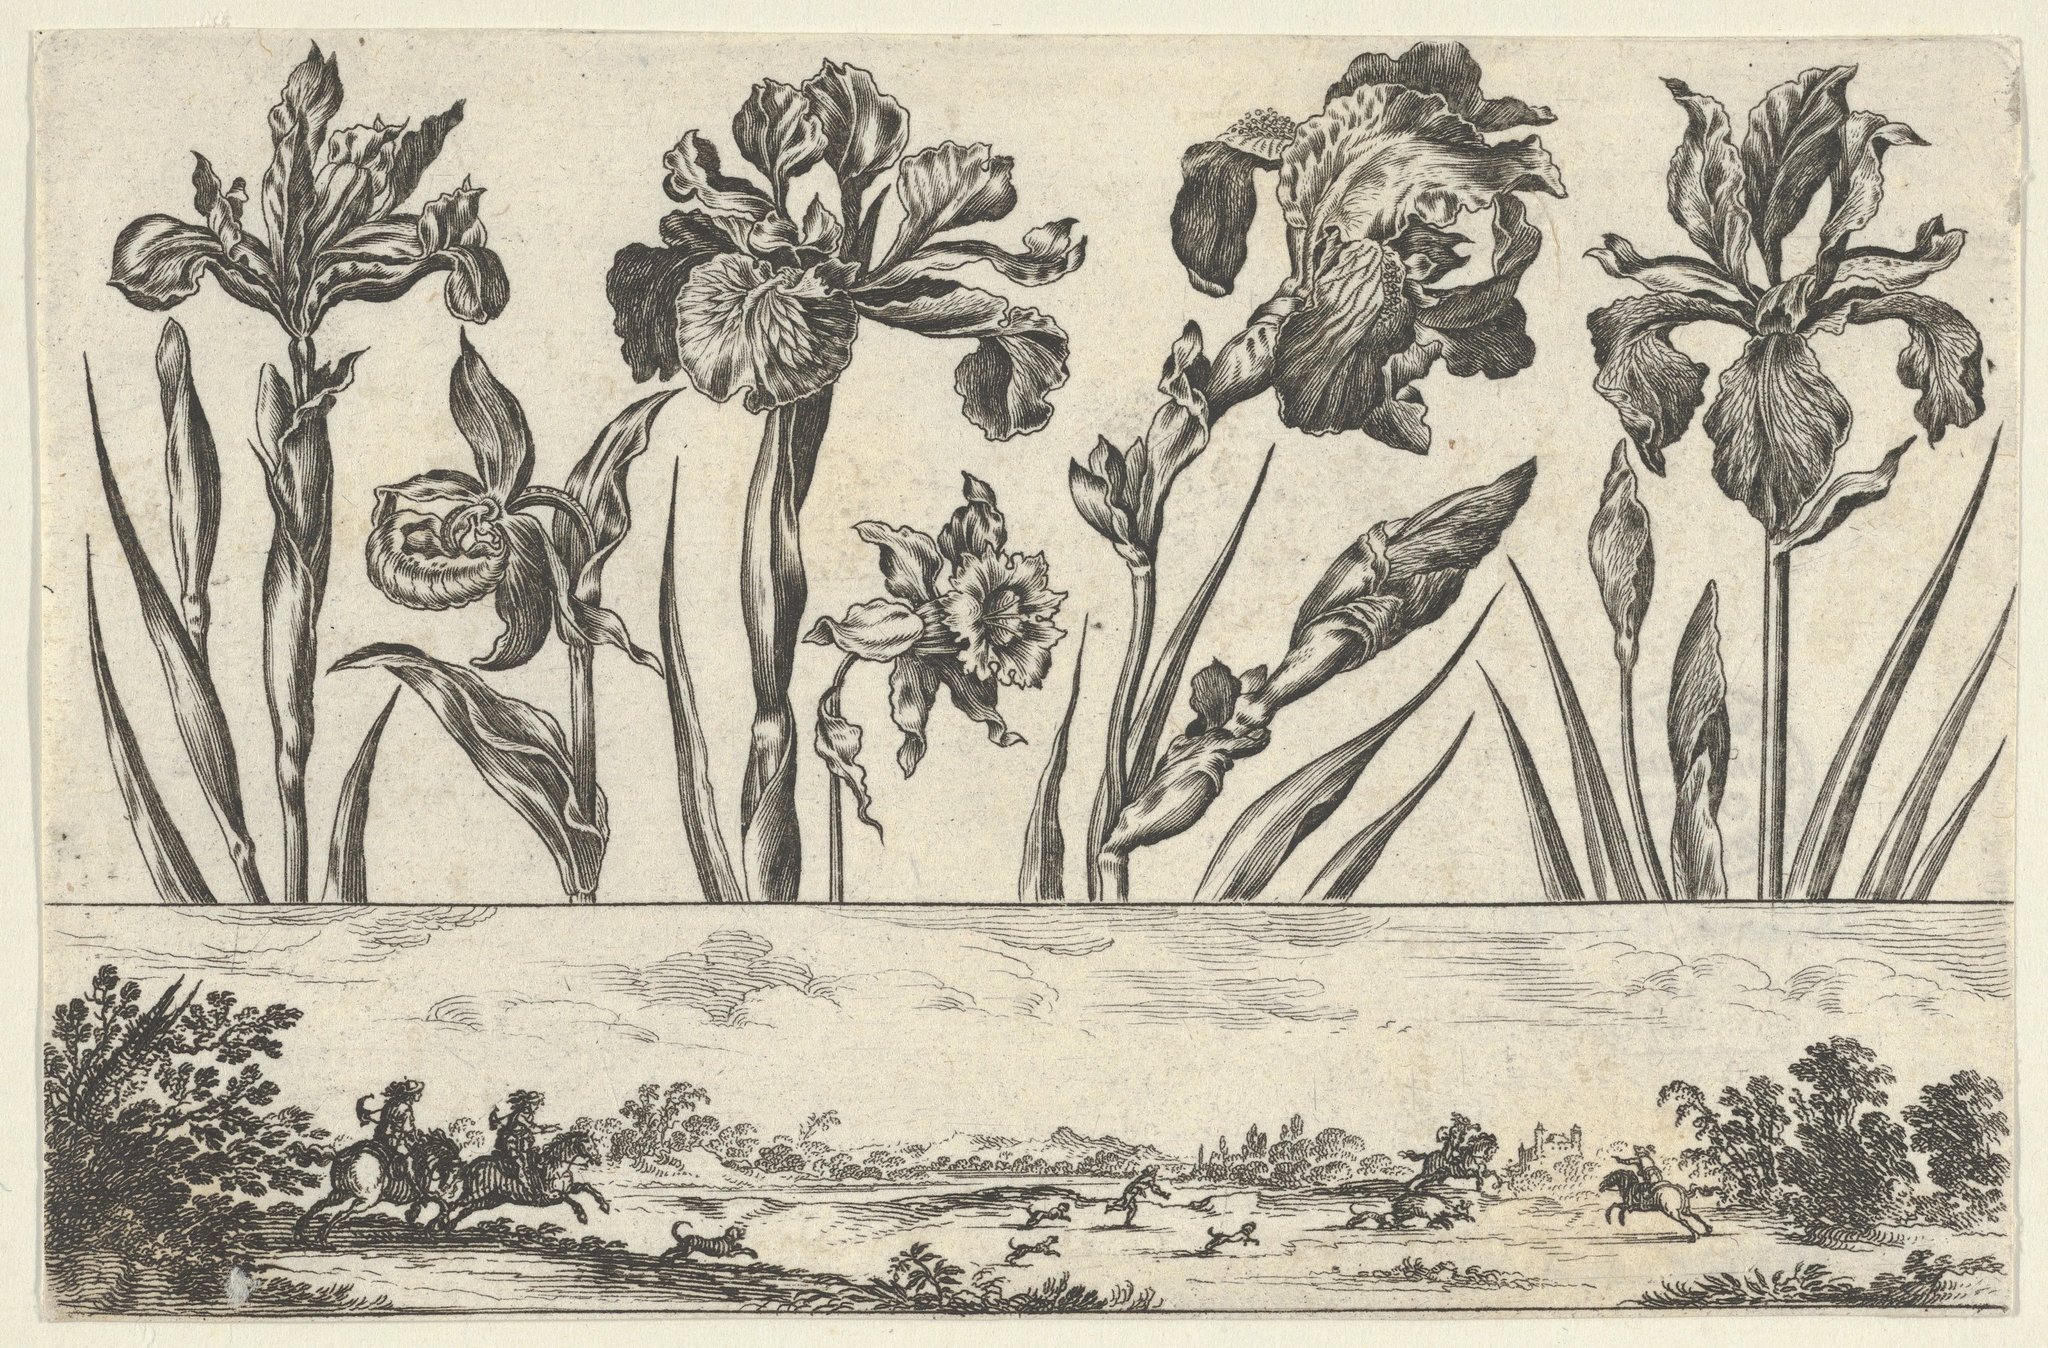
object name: print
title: Horizontal Panel with a Row of Flowers Above a Frieze with a Hunting Scene in a Landscape, from "Livre Nouveau de Fleurs Tres-Util"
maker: nicolas cochin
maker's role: artist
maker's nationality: french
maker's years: 1610-1686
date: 1645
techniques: engraving, etching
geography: france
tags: men,hunting,horses,flowers,landscapes